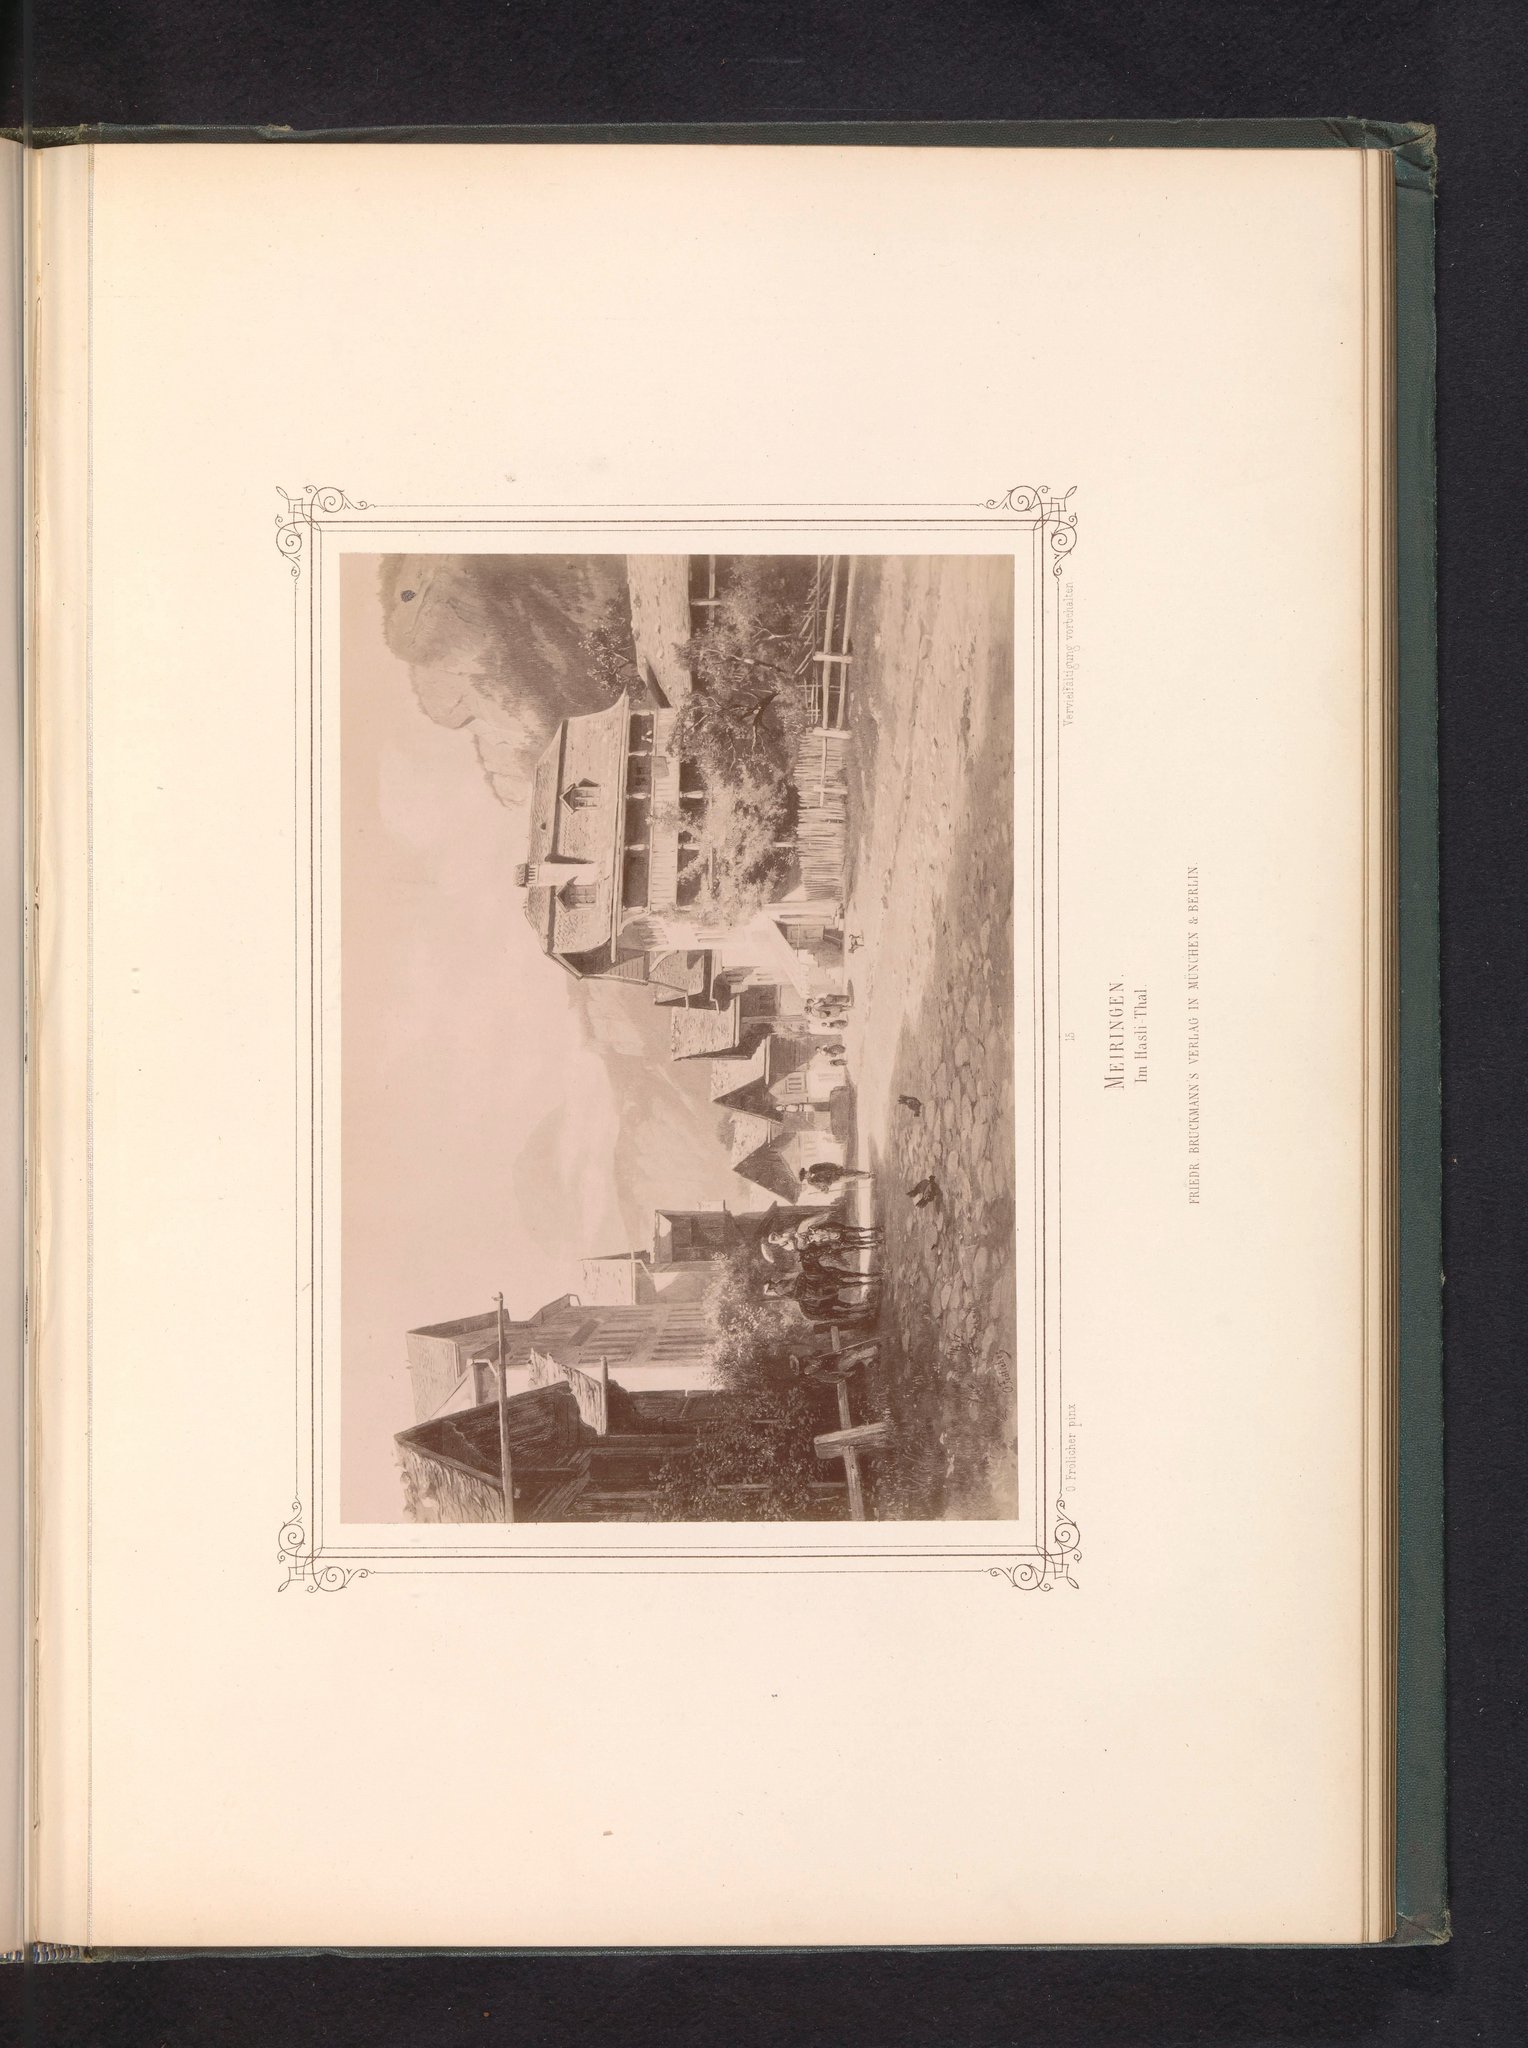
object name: page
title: Fotoreproductie van een schilderij van een gezicht op Meiringen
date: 1863-1873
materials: photographic support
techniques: albumen print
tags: street, mountains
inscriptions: number: ‘15.’